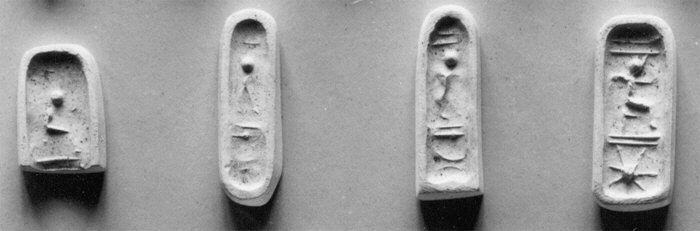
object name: stamp seal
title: Stamp seal (in the shape of a foot, with loop handle) with deities (?) and anthropomorphic figures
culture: phoenician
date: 900-601 BCE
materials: stone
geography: cyprus or syria